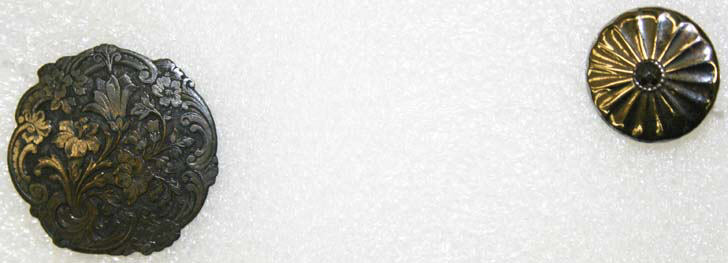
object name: button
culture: american or european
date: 1850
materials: metal